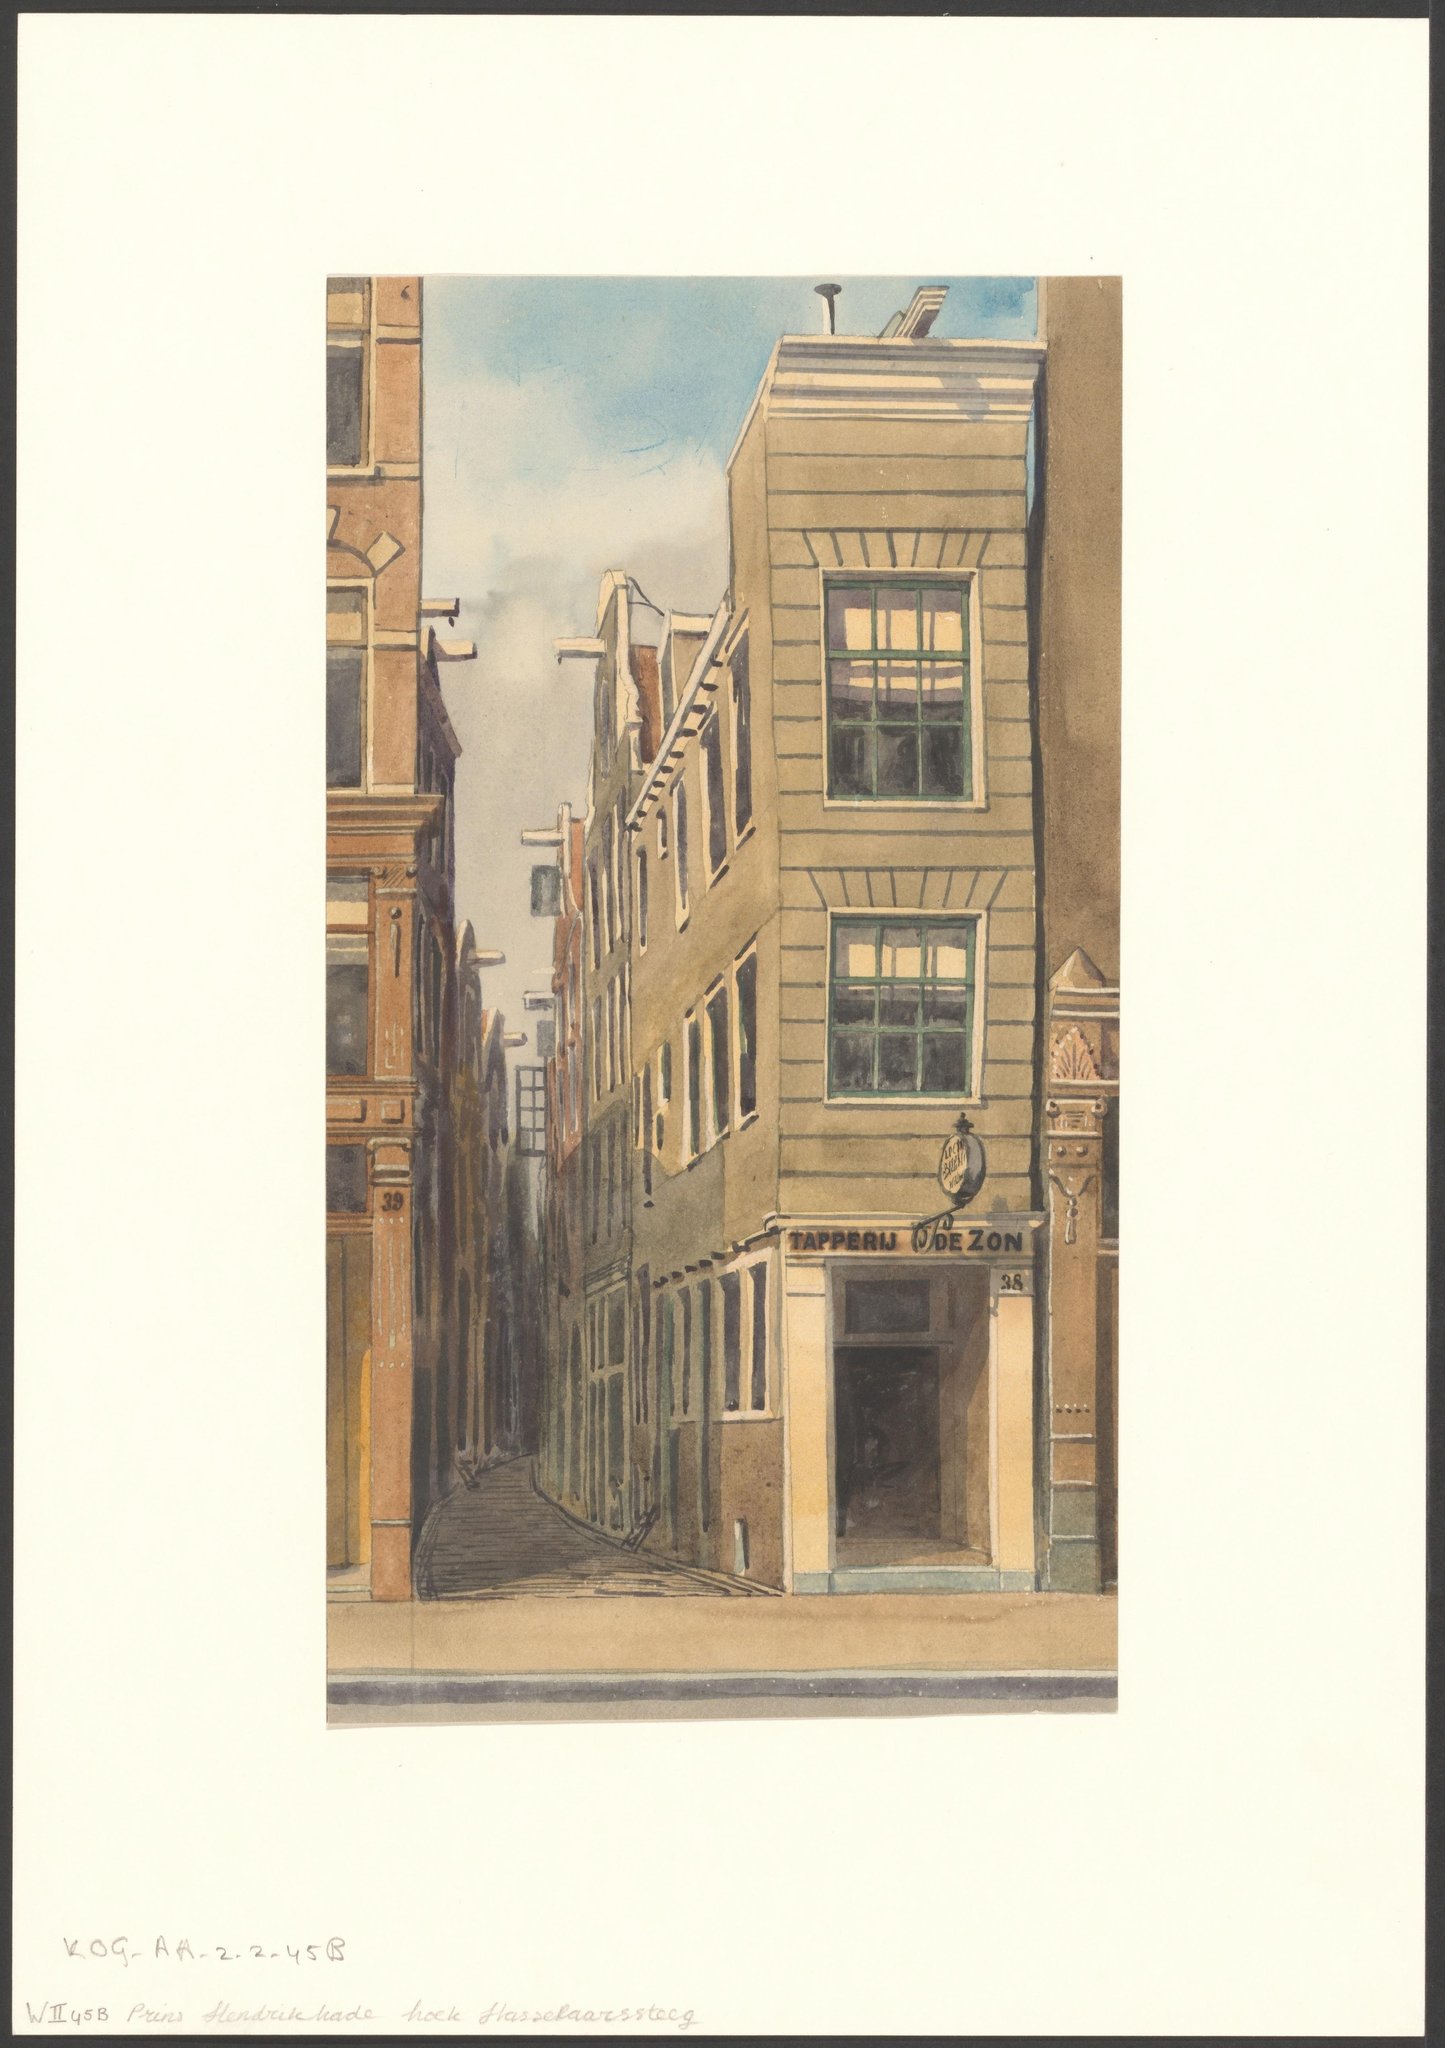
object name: drawing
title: Gevel van de Prins Hendrikkade 38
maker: Anonymous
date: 1875-1905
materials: gouache, paper, pencil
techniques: brush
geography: amsterdam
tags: city-view in general; 'veduta', façade (of house or building)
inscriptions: inscription: ‘Prins Hendrik Kade 38 / met de Perseelen Hasselaarsteeg 2.4.5.6.8.10.11.14 / " " " " 7.12 gedeeltelijk / bij Raadsbesluit v. 12 April 1905 / onbewoonbaar verklaard. / Henni[...]ët.’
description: Tekening binnen de Atlas Van Eck ingedeeld op wijknummer 2.